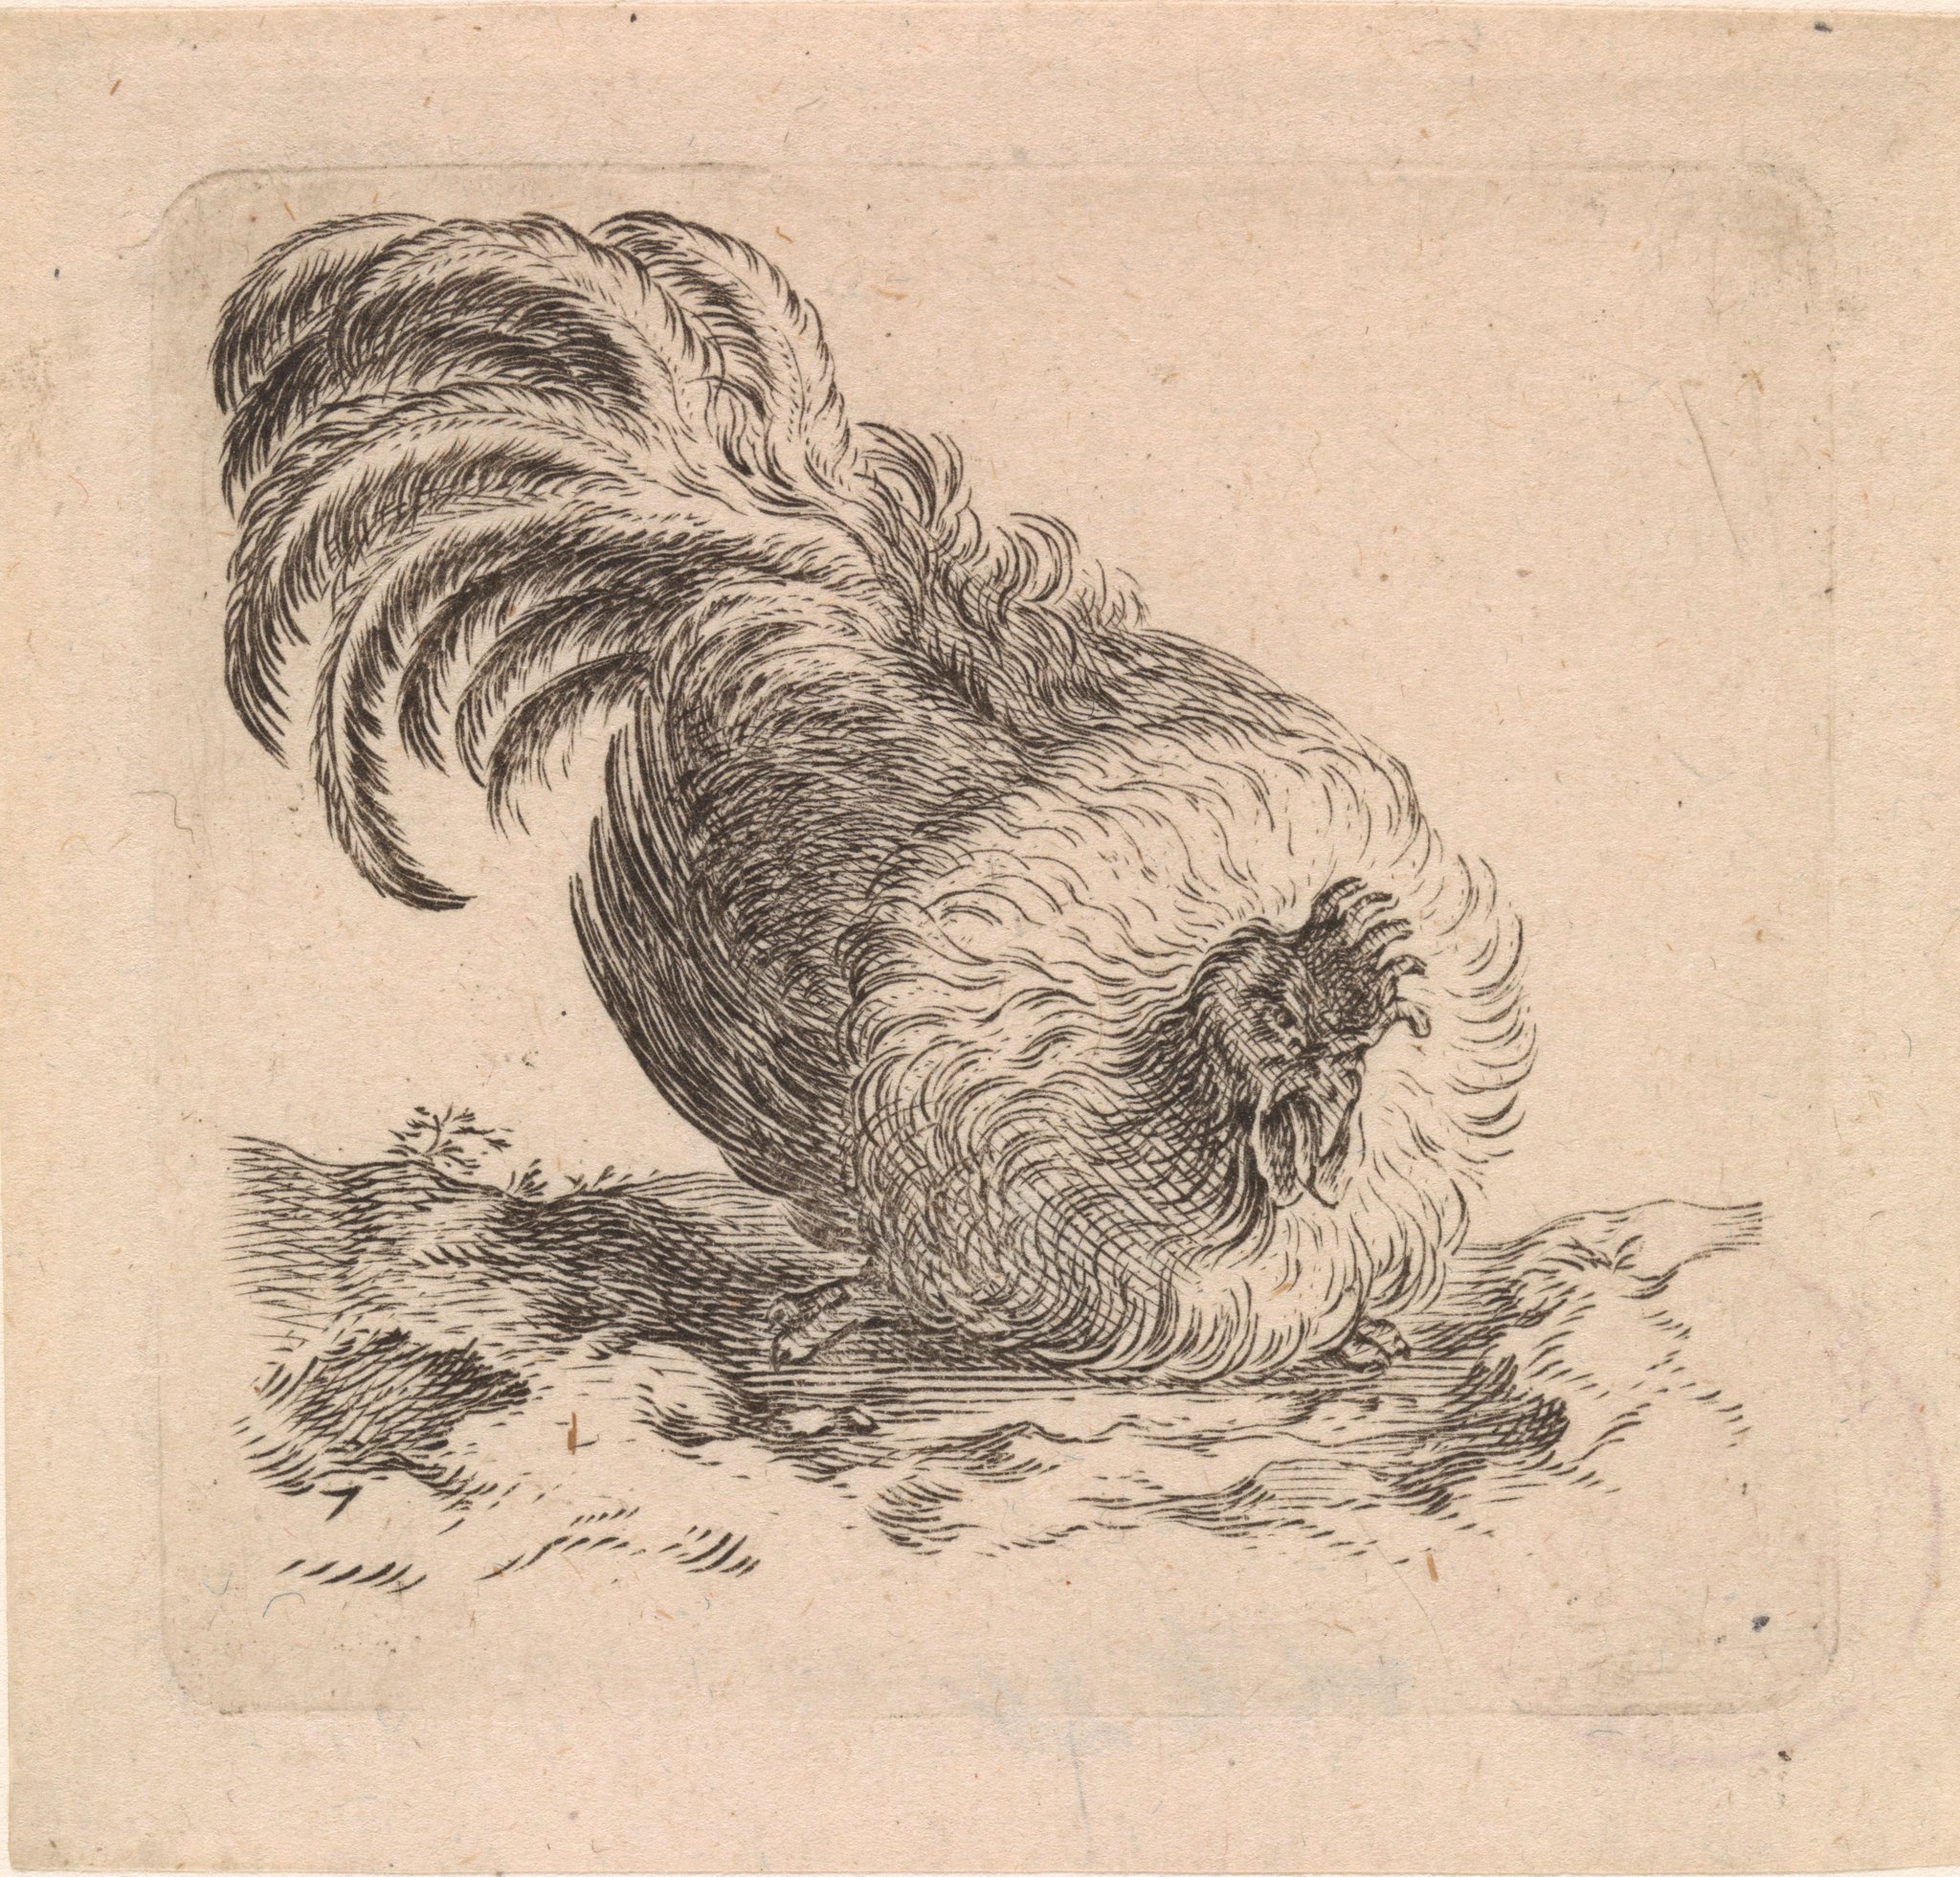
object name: print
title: Boerderij beesten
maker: cornelis saftleven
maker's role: draughtsman, painter, print maker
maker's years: 1607-1681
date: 1617-1681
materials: paper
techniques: etching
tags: fowl (cock, hen, chicken, etc.)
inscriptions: collector's mark: Lugt 240